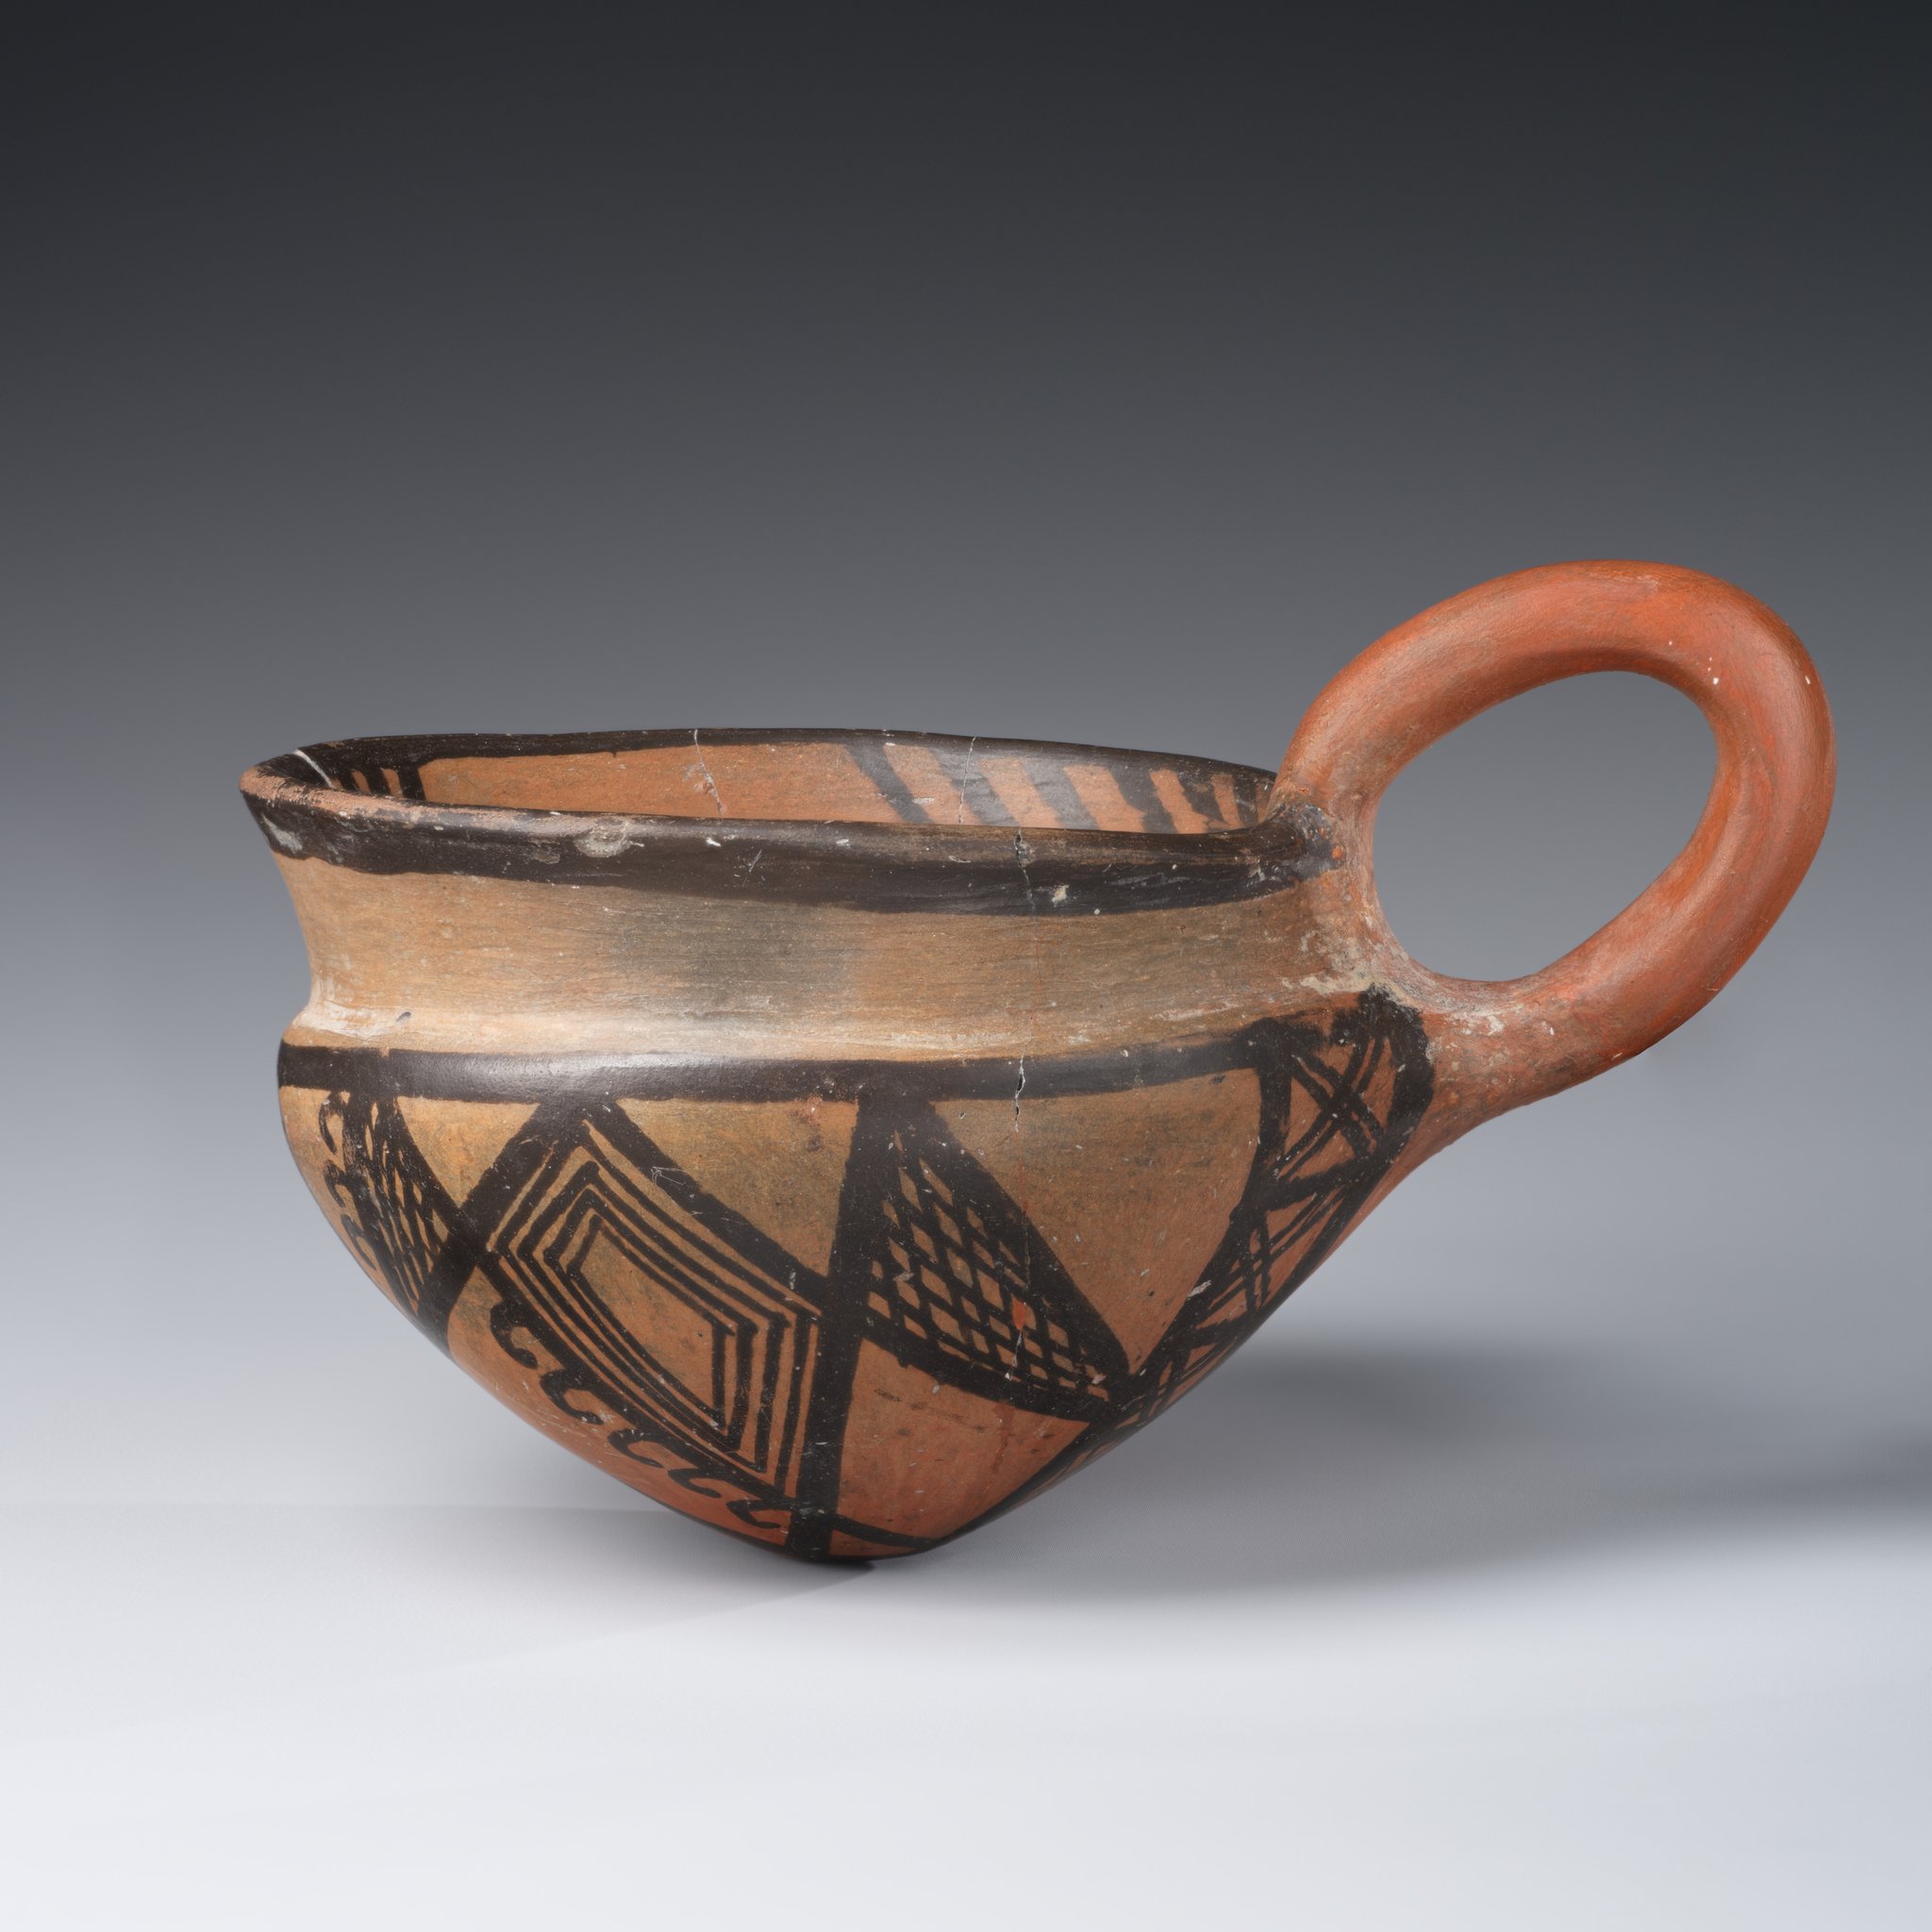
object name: vessel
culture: old assyrian or hittite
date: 1900-1600 BCE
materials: ceramic, paint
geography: central anatolia